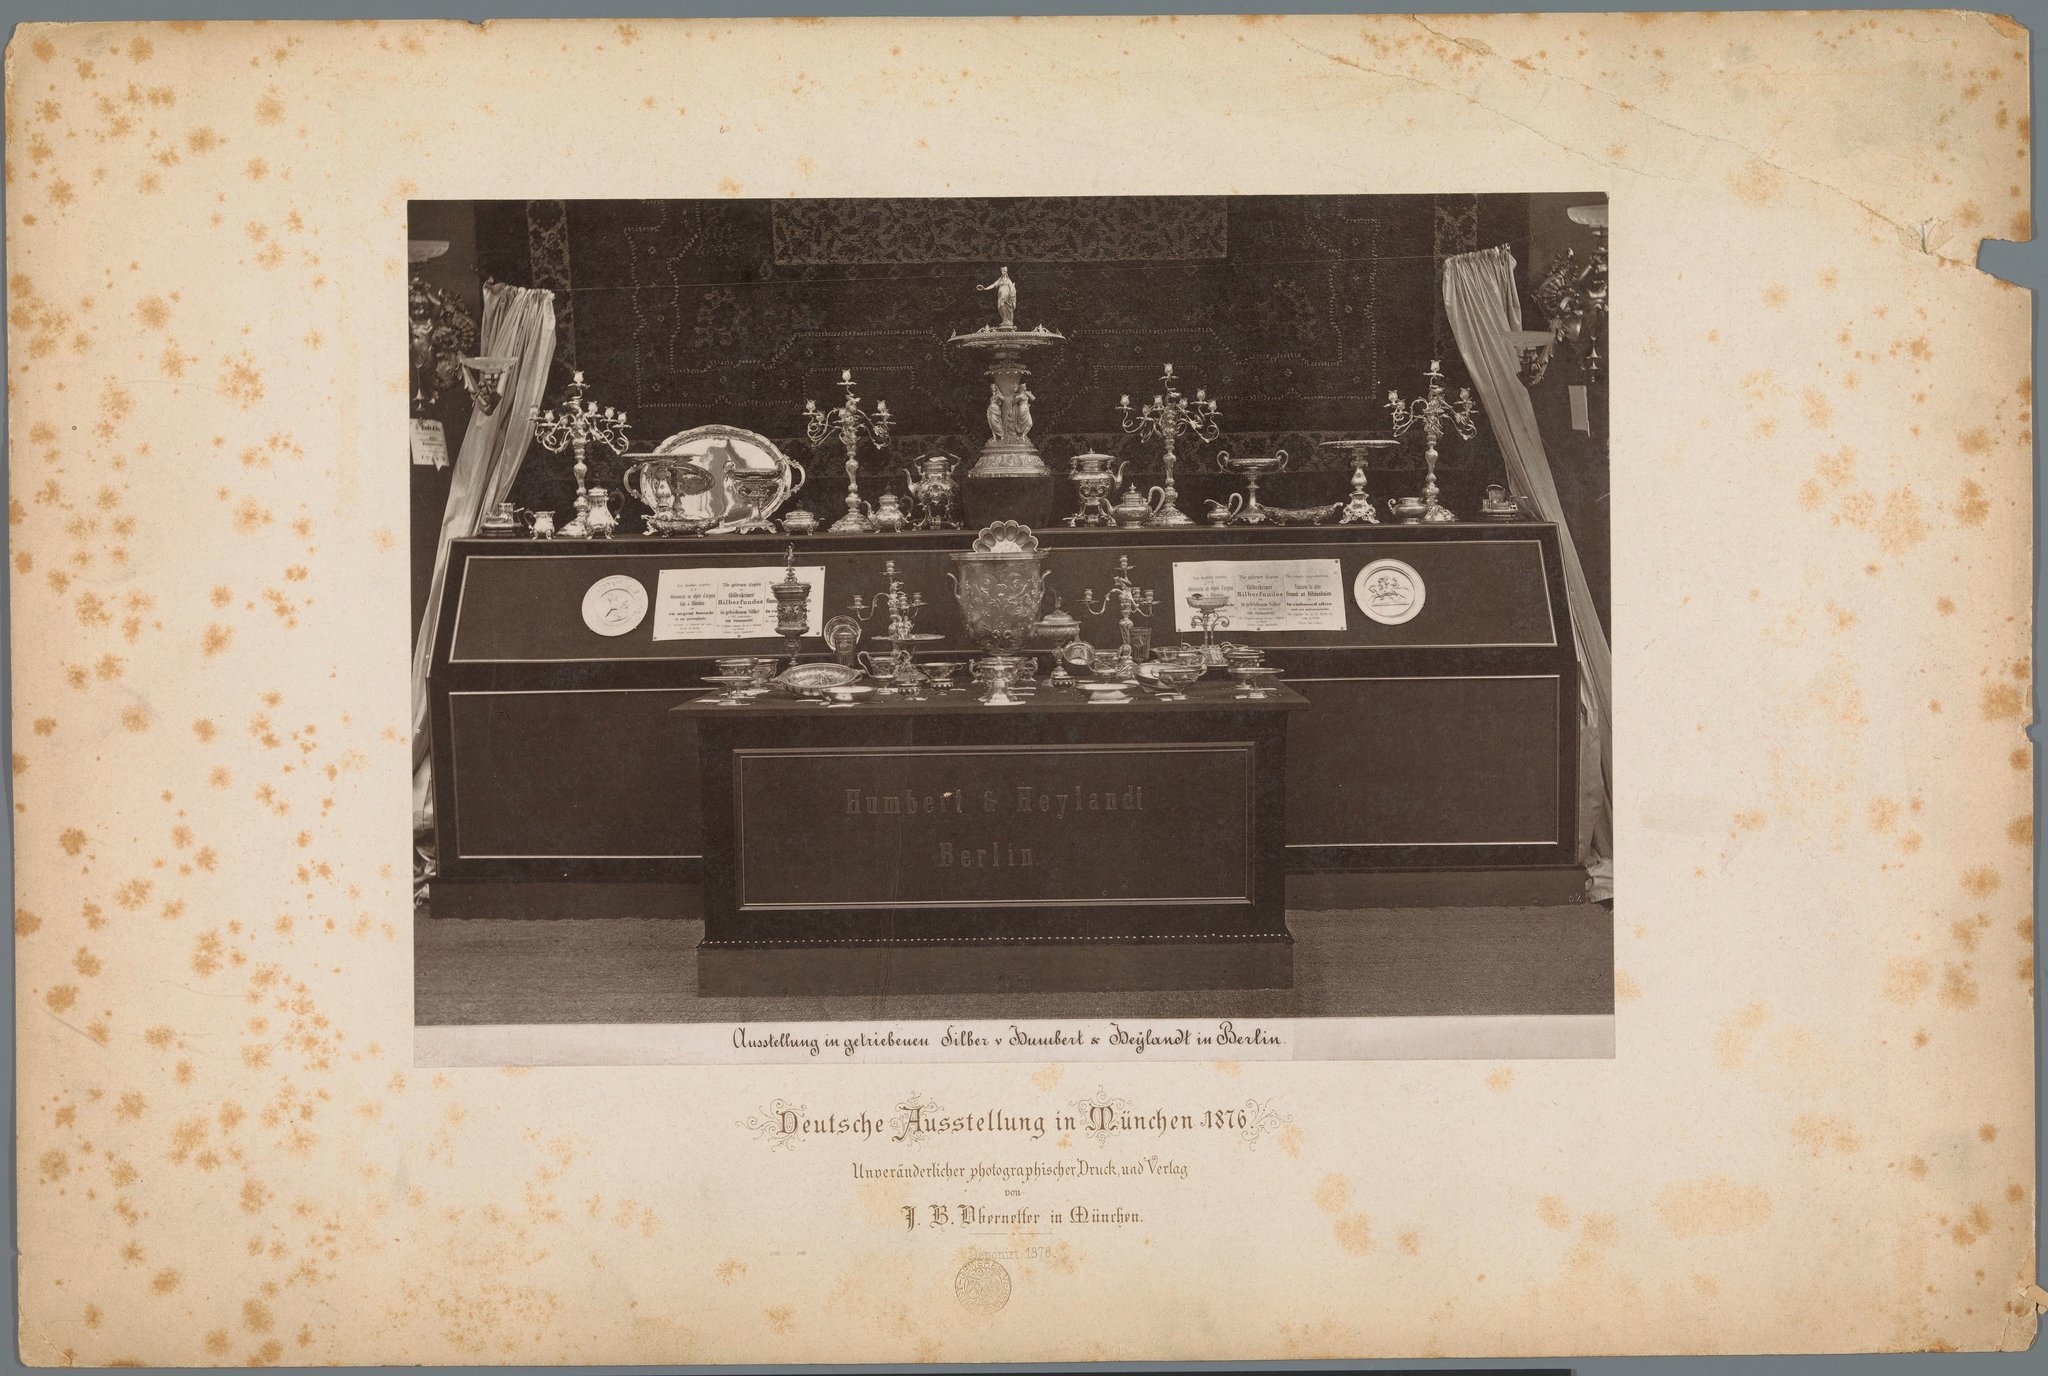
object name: photograph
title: Opstelling van zilverwerk te München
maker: johann baptist obernetter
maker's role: printer, publisher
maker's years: 1840-1887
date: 1876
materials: cardboard, paper, ink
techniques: photograph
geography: munich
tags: chandelier, candelabrum, collection, exhibition, show, container of precious metal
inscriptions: inscription: ‘Deutsche Ausstellung in München 1876. ’, name: ‘KUNST-GEWERBE VEREIN’, collector's mark: Lugt 3937, number: ‘67.’